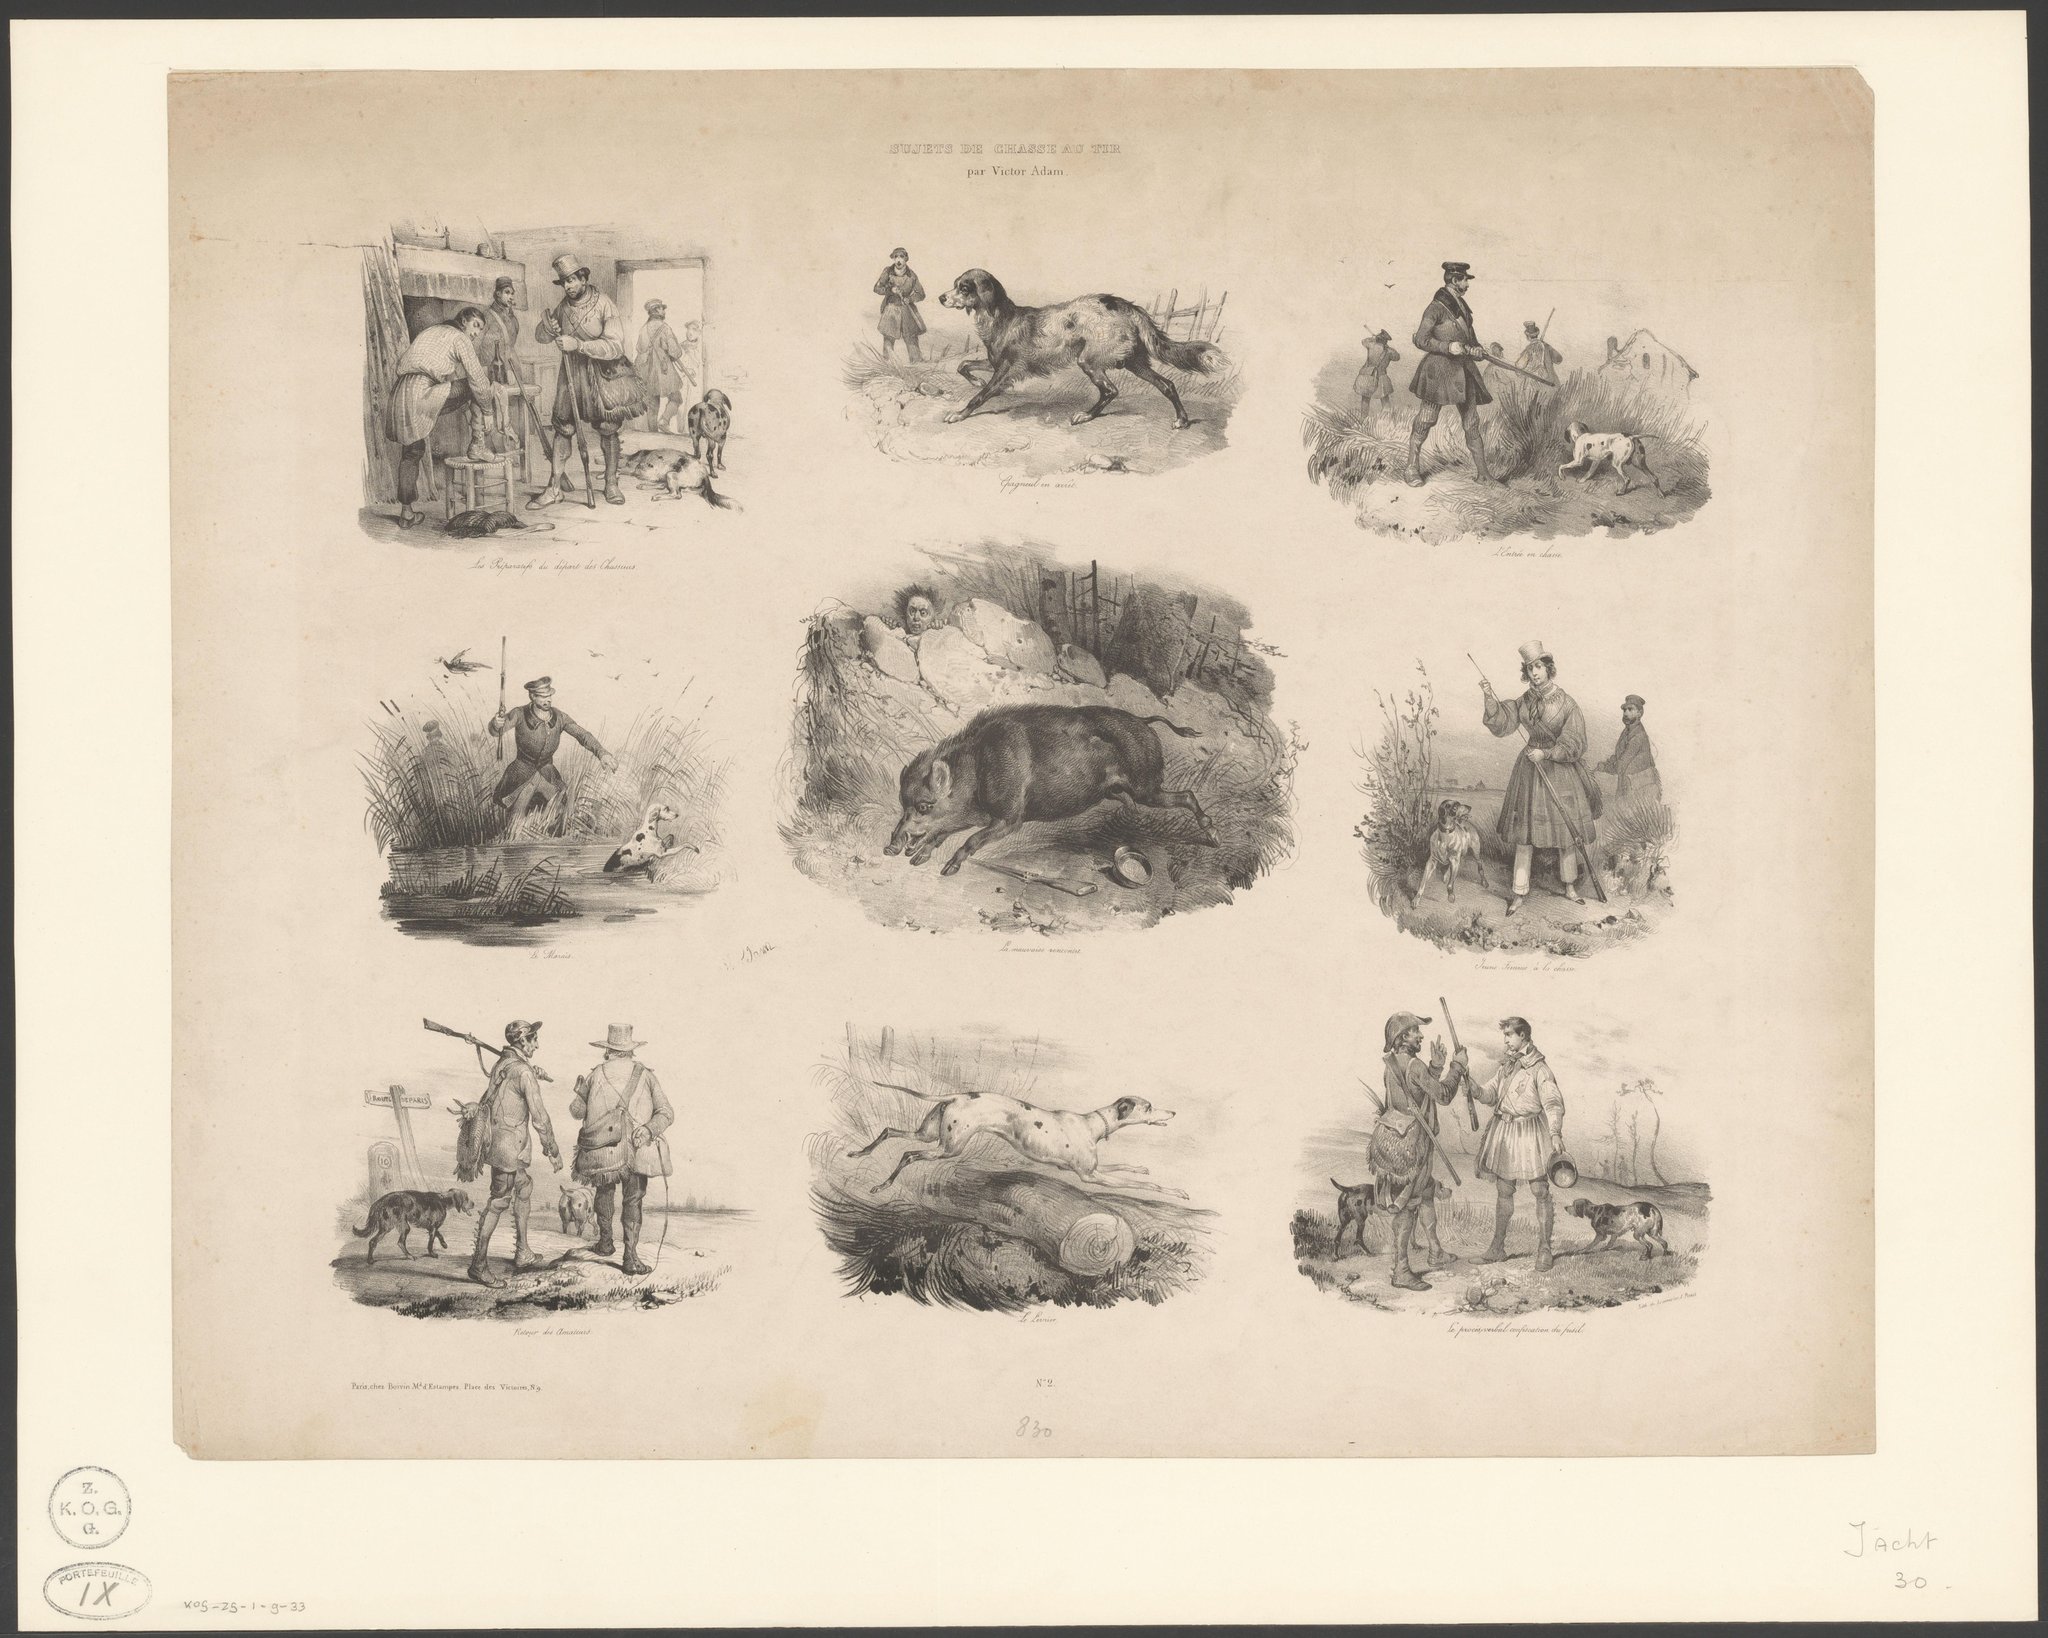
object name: print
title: Jachtonderwerpen met geweer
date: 1827-1873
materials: paper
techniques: lithograph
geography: paris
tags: hunter, game, hunted animals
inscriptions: collector's mark: Lugt 1641, stamp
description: Negen voorstellingen van de jacht met het geweer, van de voorbereidingen voor de jacht tot de terugkeer. Onderaan genummerd: No. 2. Onderwerpsrubrieken binnen de Atlas Zeden en Gewoonten: Handel, nijverheid en verkeer, jacht.